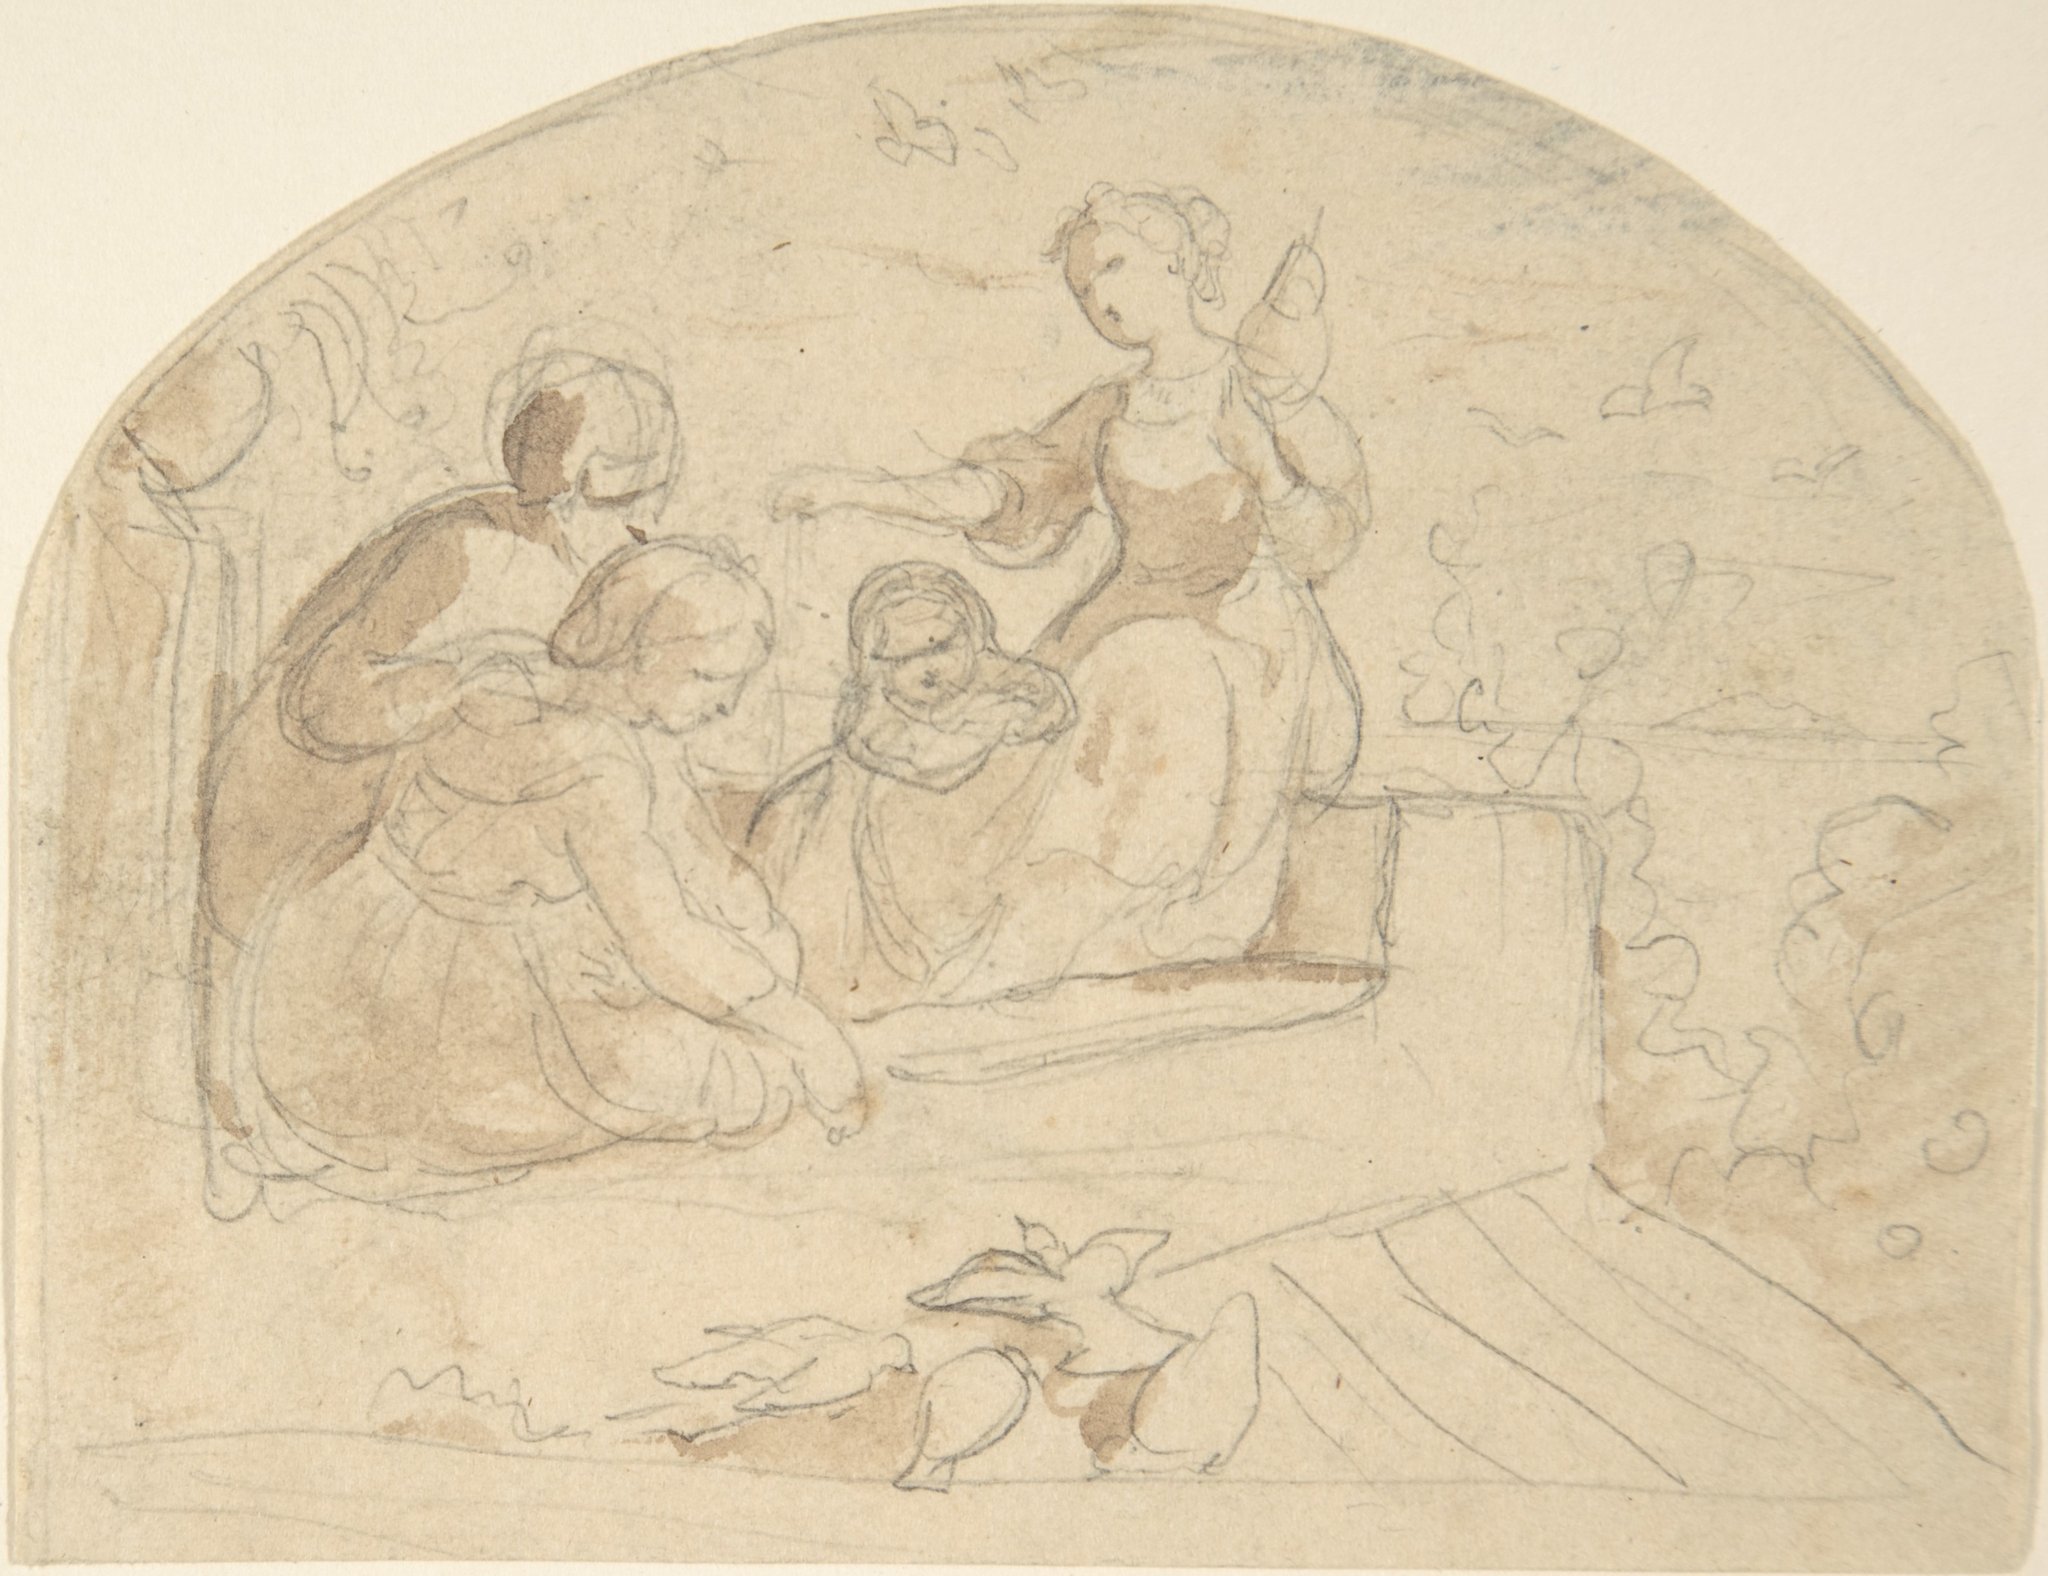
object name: drawing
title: Three Women and a Child on a Roof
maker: adrian ludwig richter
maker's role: artist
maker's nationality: german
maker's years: 1803-1884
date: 1820-1884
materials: graphite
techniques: brush, wash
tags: birds,roofs,infants,women